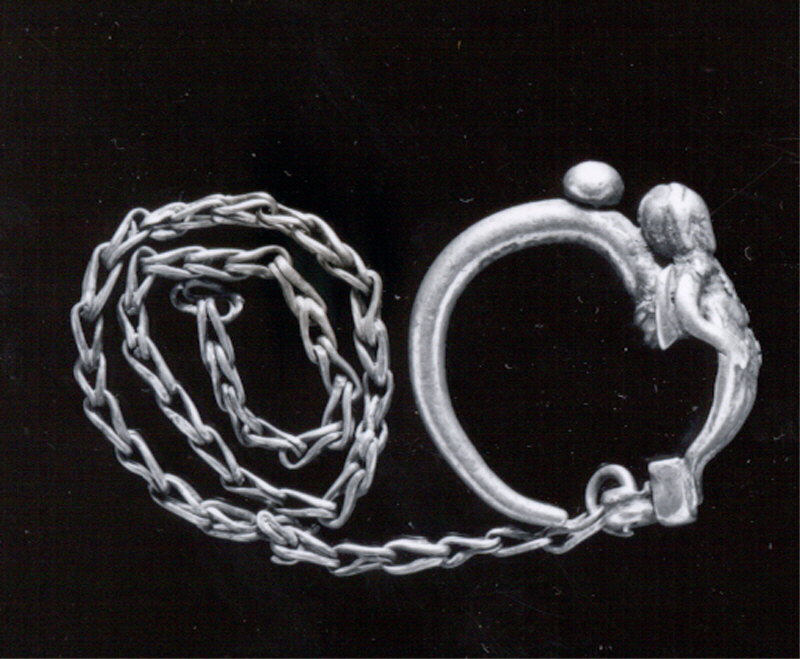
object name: earring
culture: parthian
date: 300-101 BCE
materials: silver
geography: iran (?)